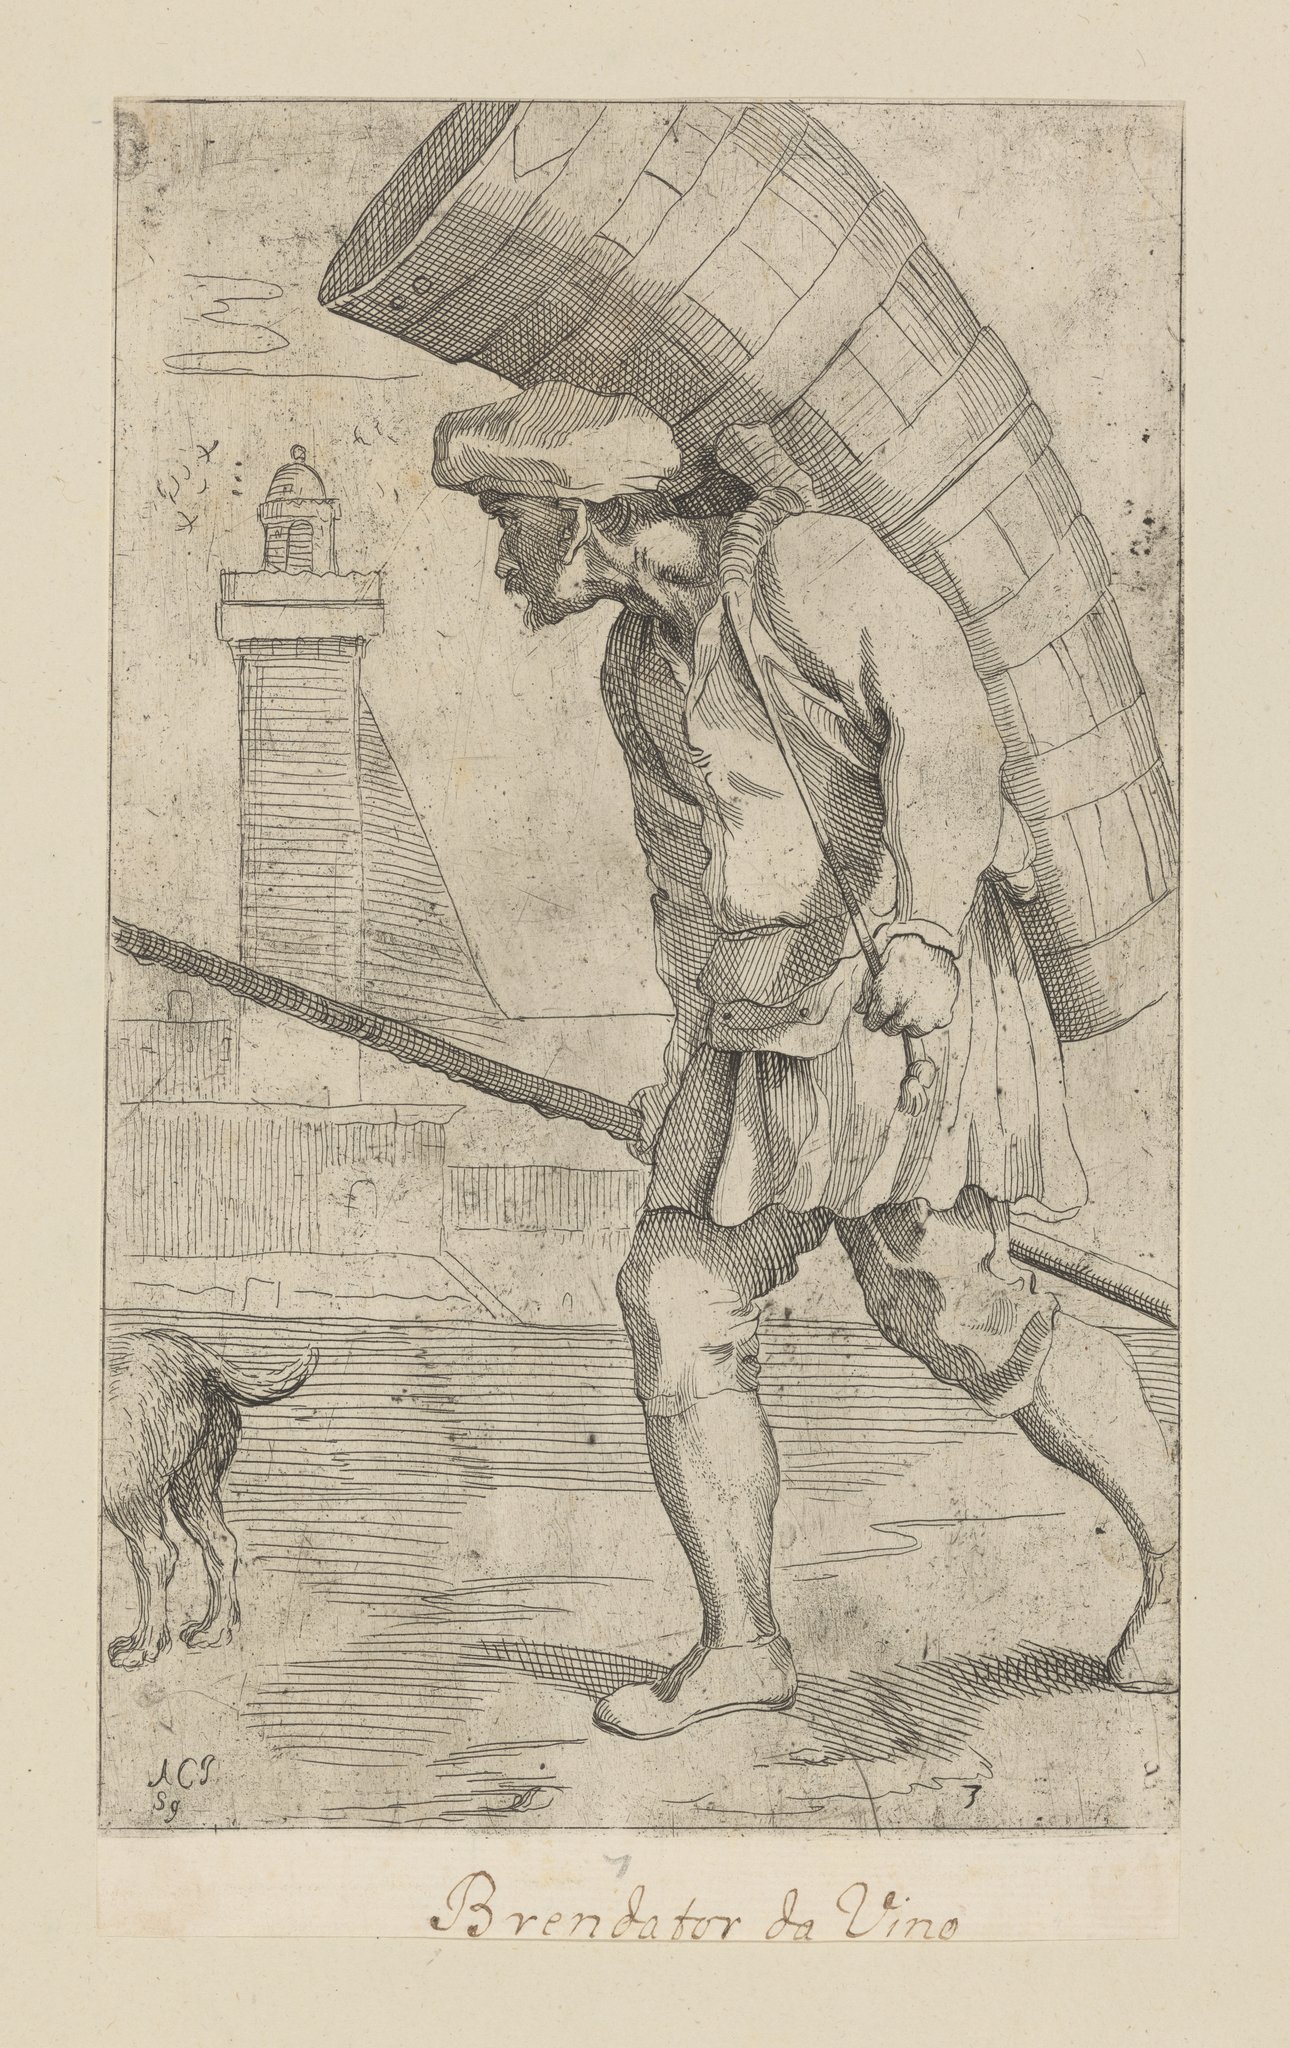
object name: print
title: Plate 3: Porter carrying grapes (for wine)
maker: simon guillain ii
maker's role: artist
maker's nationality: french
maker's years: 1618-1718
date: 1646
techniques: etching